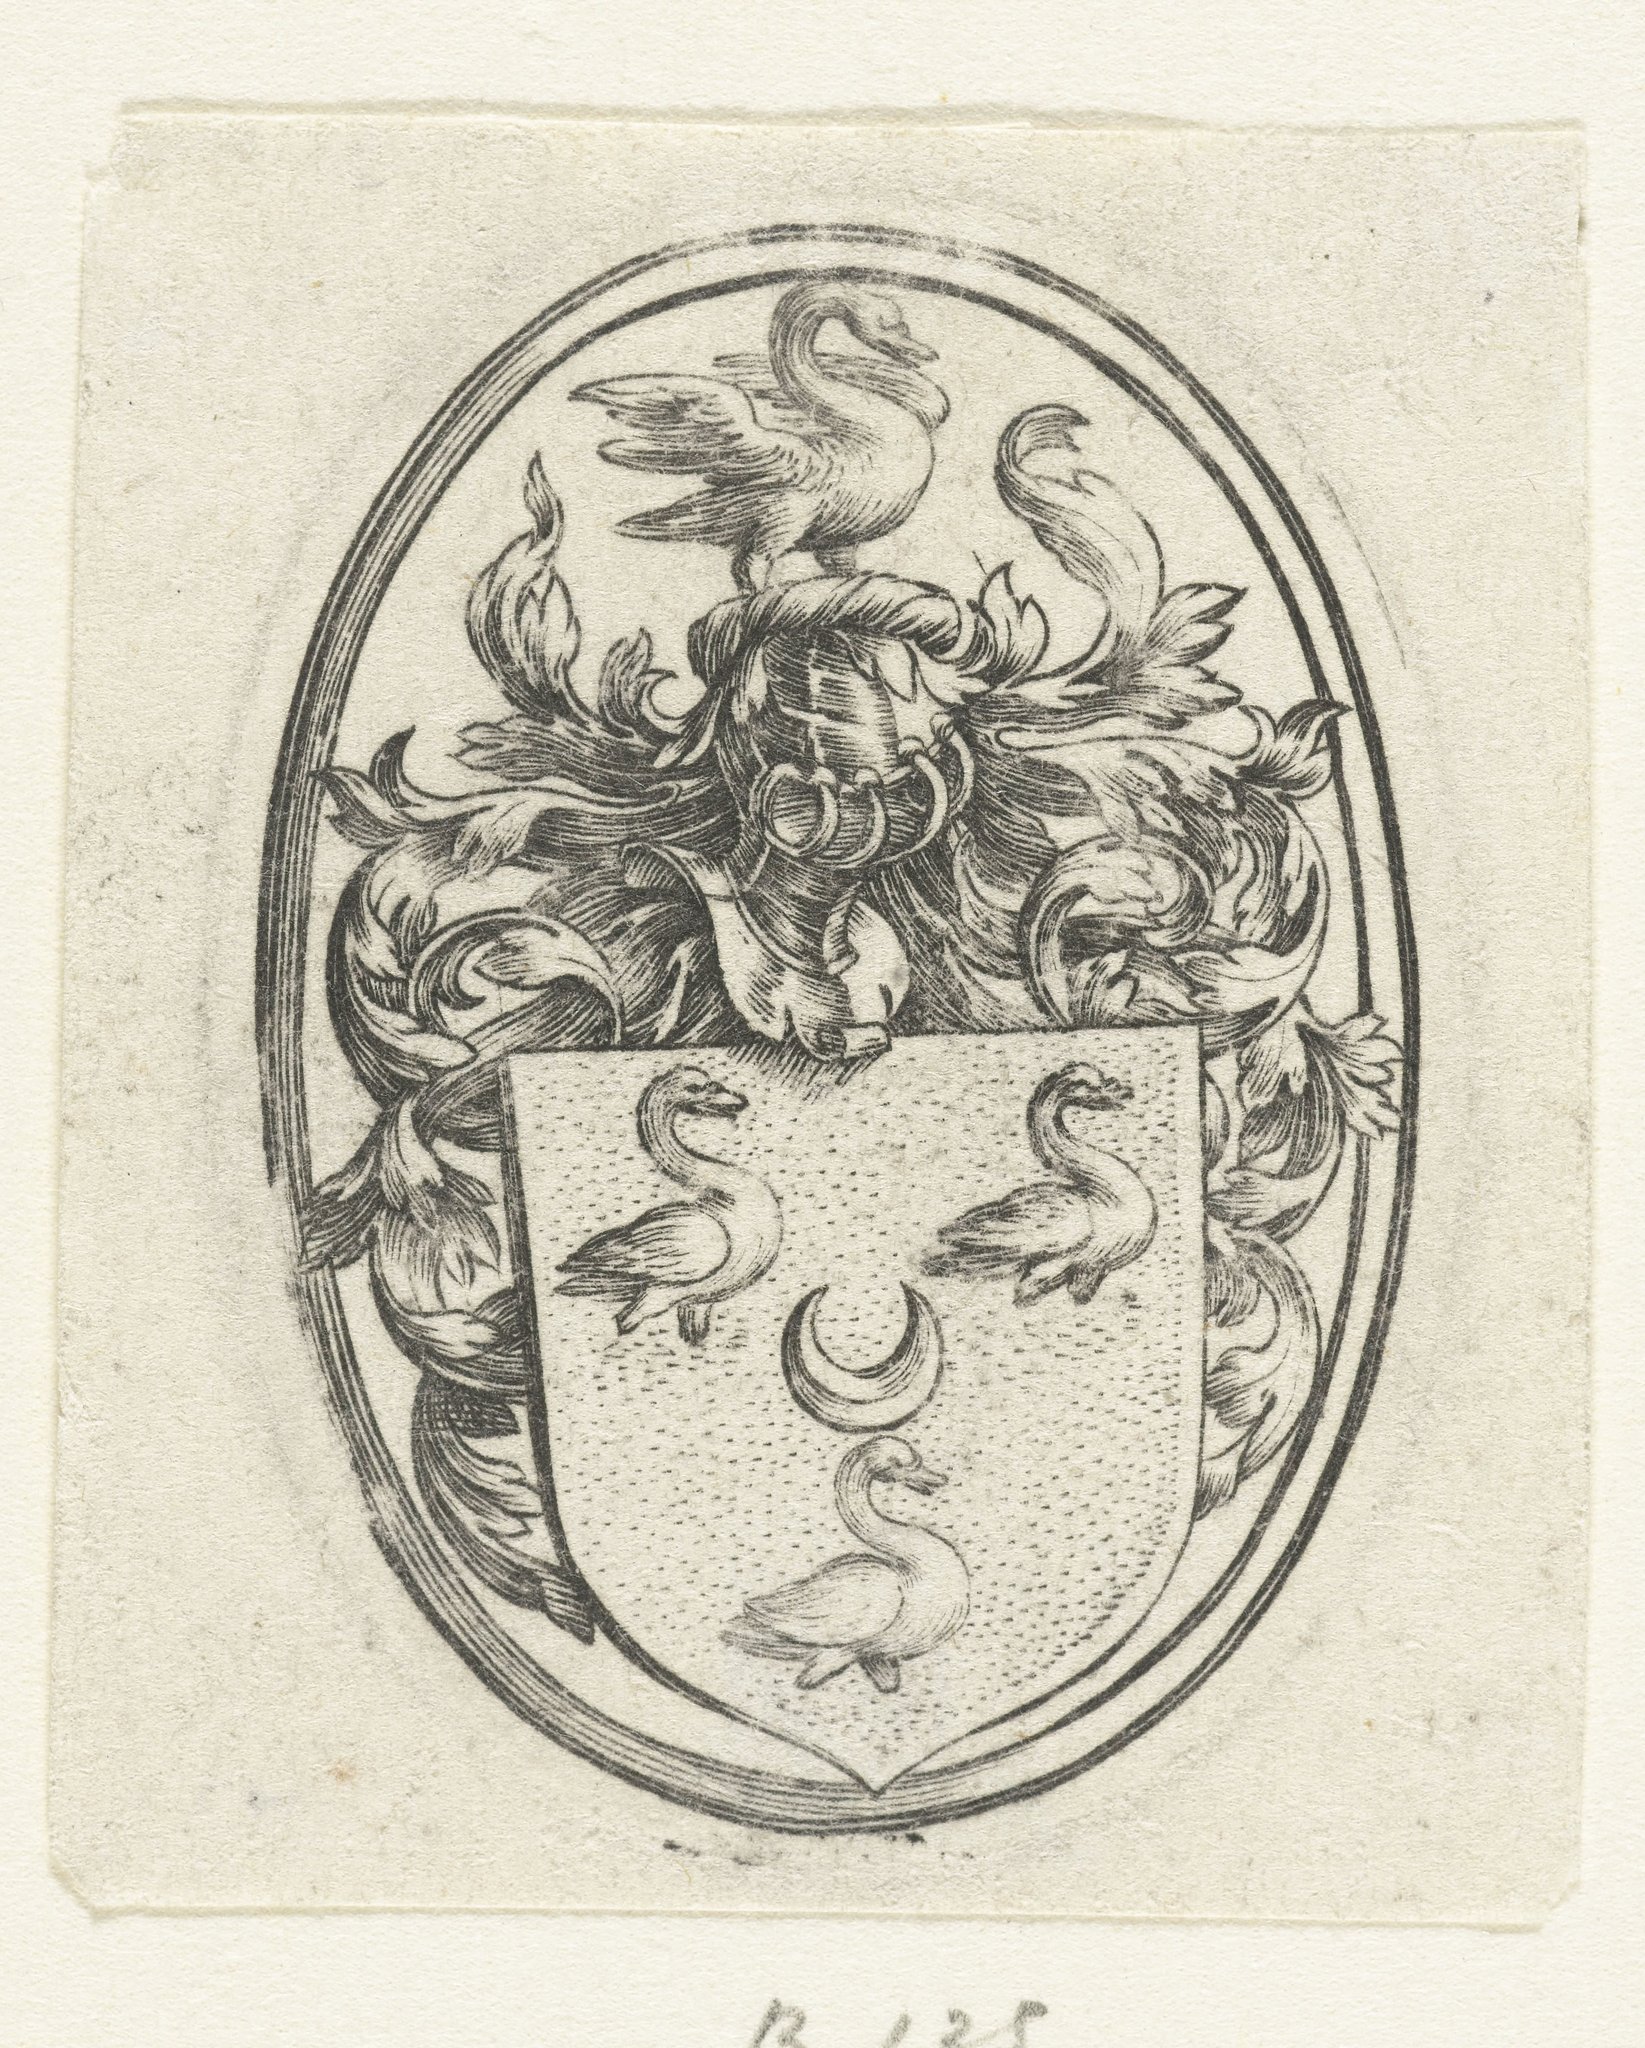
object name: print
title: Wapen van de familie Out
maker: hendrick goltzius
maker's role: draughtsman, painter, print maker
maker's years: 1558-1617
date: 1580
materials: paper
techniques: engraving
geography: haarlem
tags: armorial bearing, heraldry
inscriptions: collector's mark: Lugt 2227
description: Het familiewapen van de familie Out uit Haarlem (een halve maan met daaromheen drie zwanen) in een ovaal. Behoort bij een portret van een 26-jarige man.